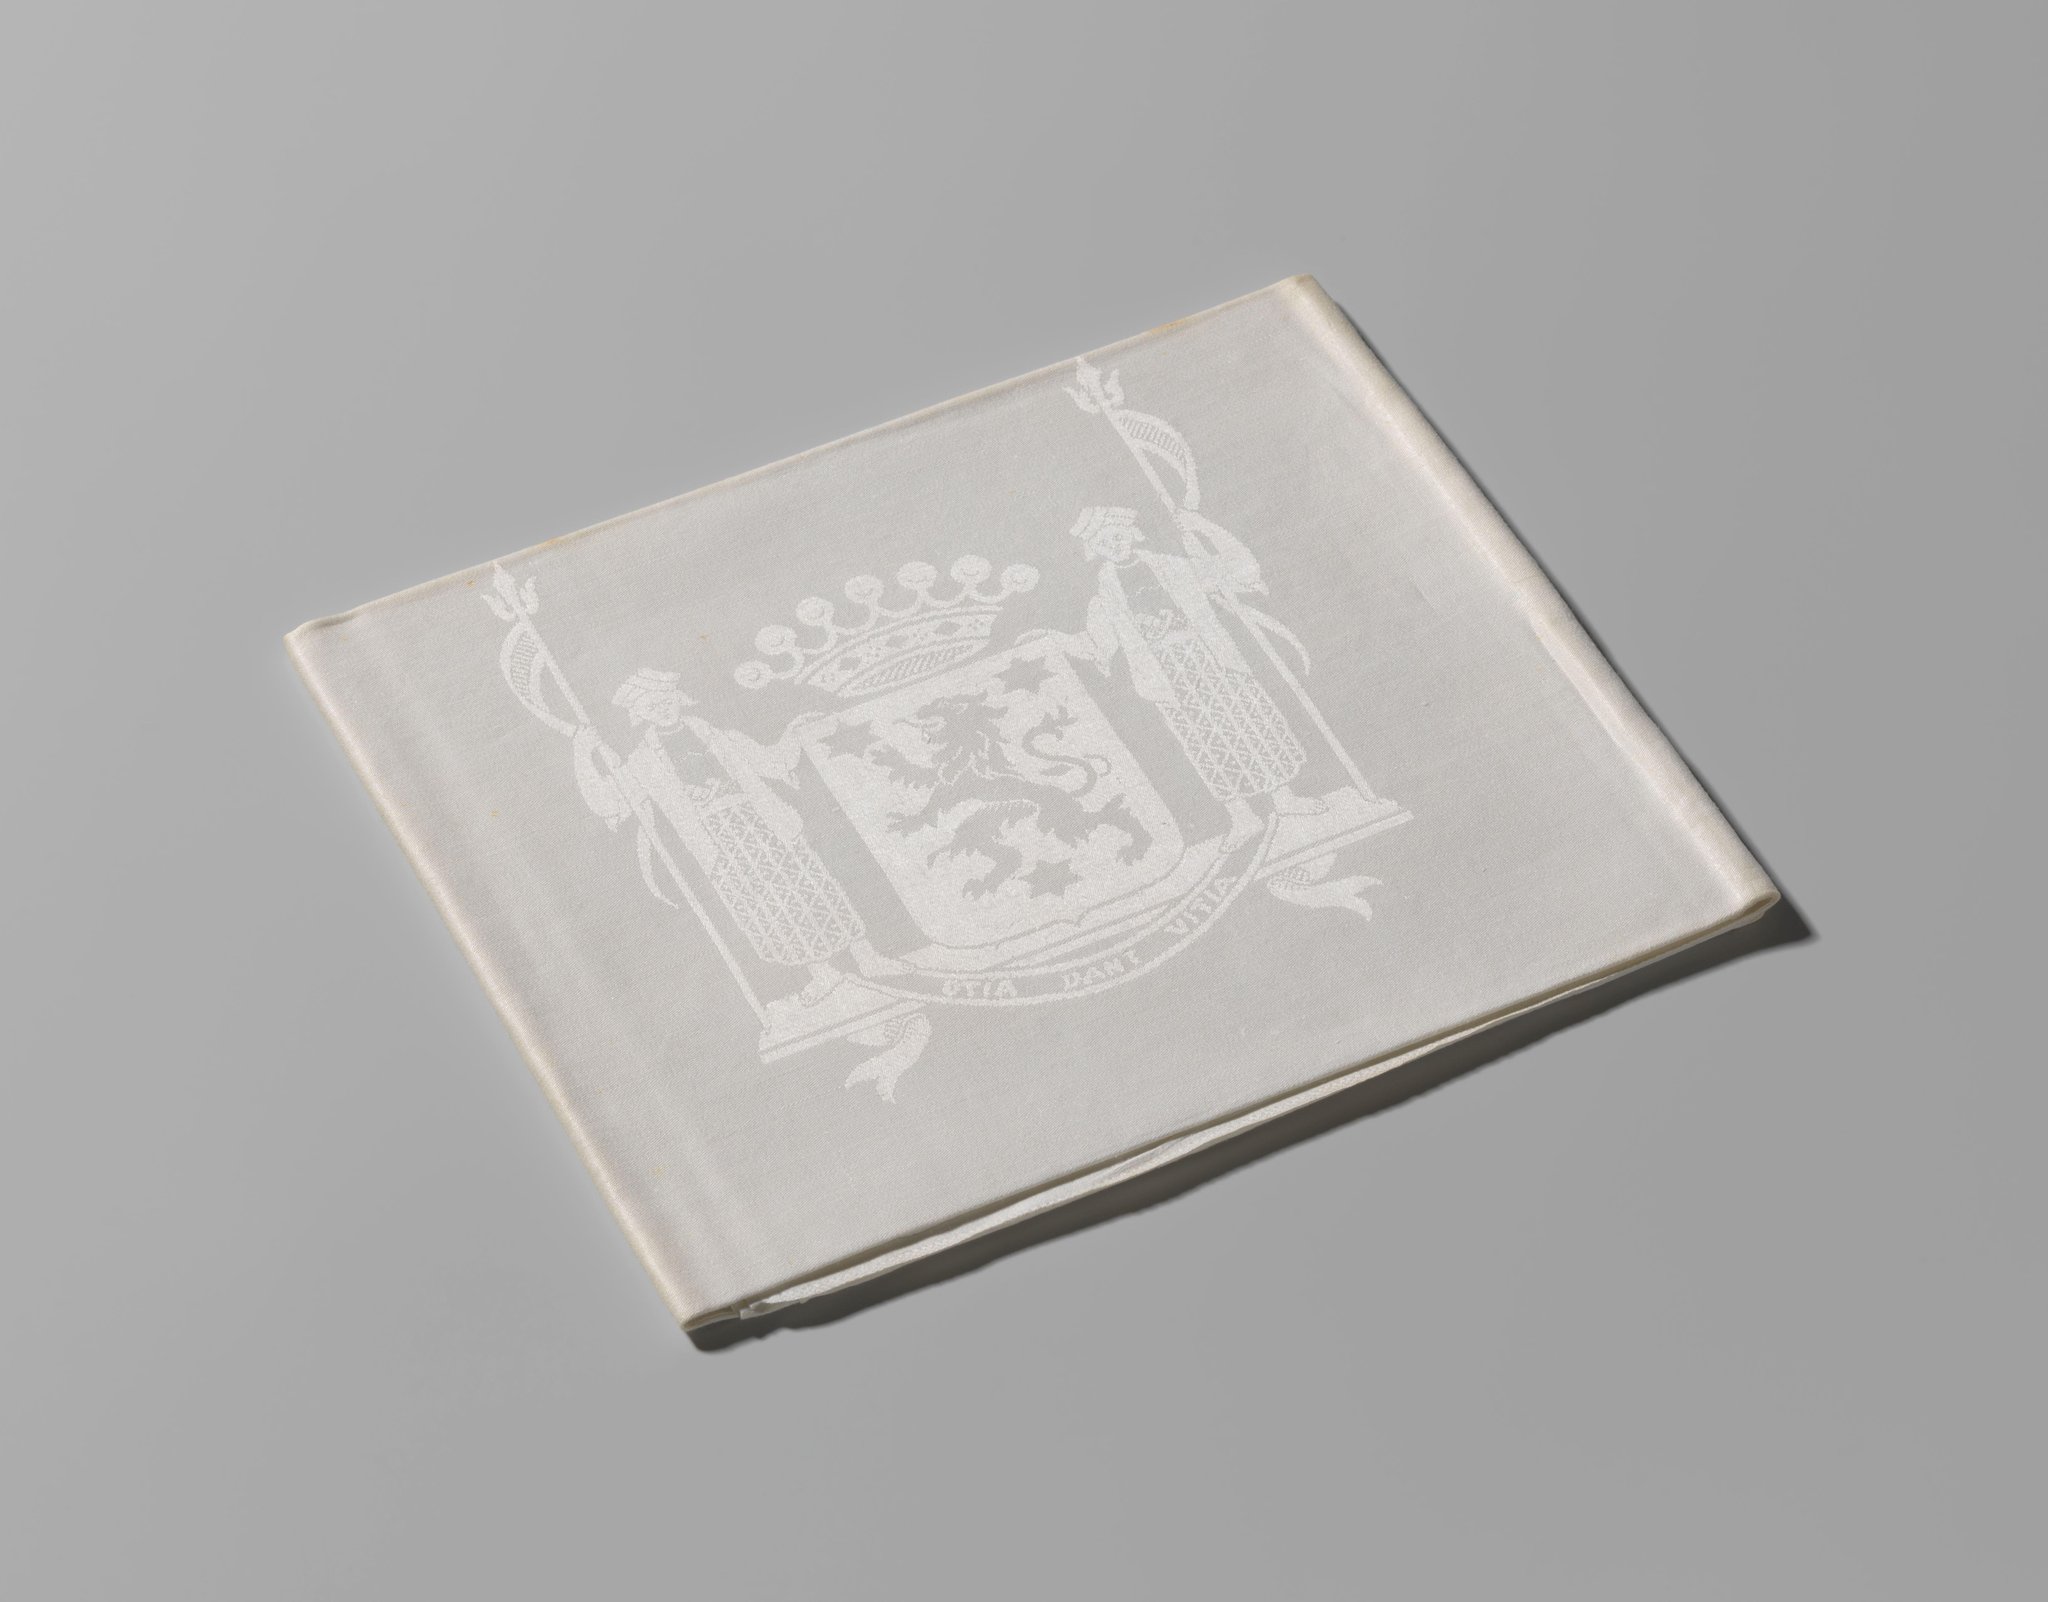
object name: napkin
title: Servet van wit linnendamast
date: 1852-1889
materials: linen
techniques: damask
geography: veghel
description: Wit linnen damasten servet met eikentakken en het wapen van de baronnen Baud. Gemerkt BvH.